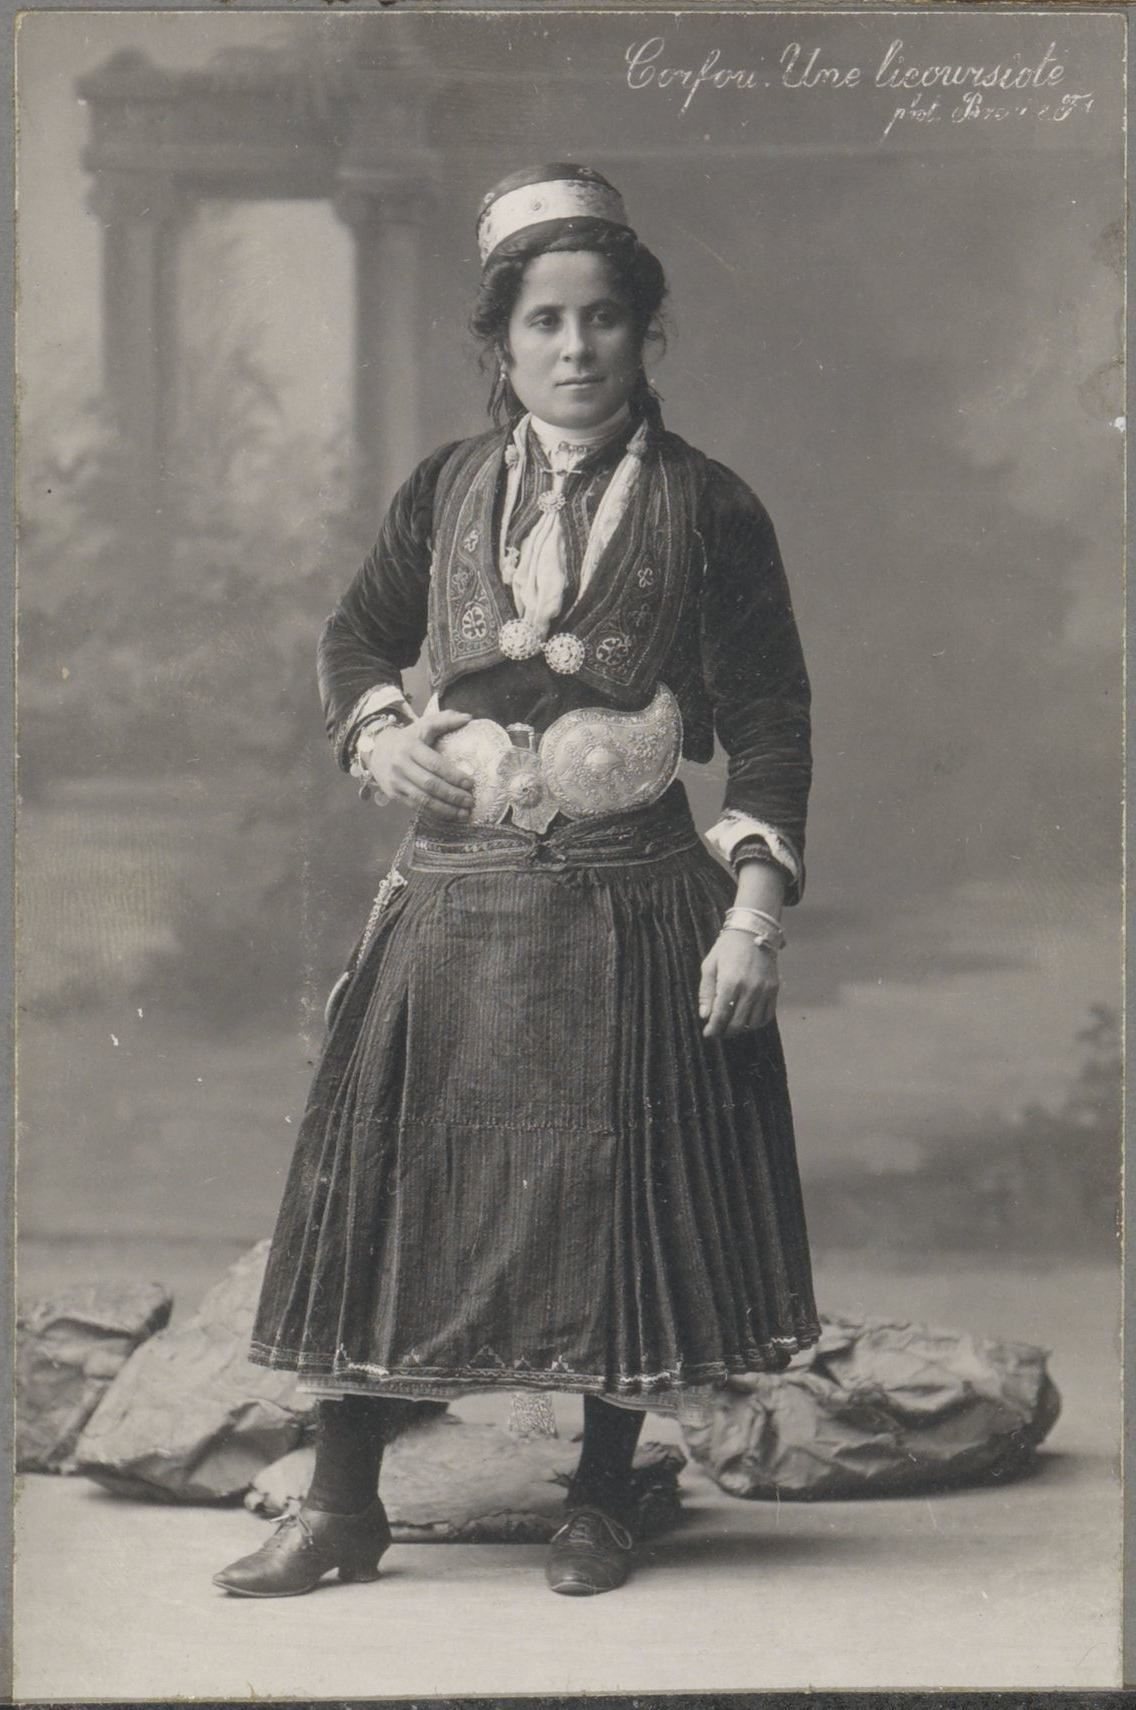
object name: album leaf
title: Corfou. Une licoursiote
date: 1895-1905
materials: paper, photographic support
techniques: gelatin silver print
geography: corfu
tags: folk costume, regional costume (+ women's clothes), studio requisites ~ photographer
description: Onderdeel van Reisalbum met foto's van bezienswaardigheden in Griekenland en Egypte.